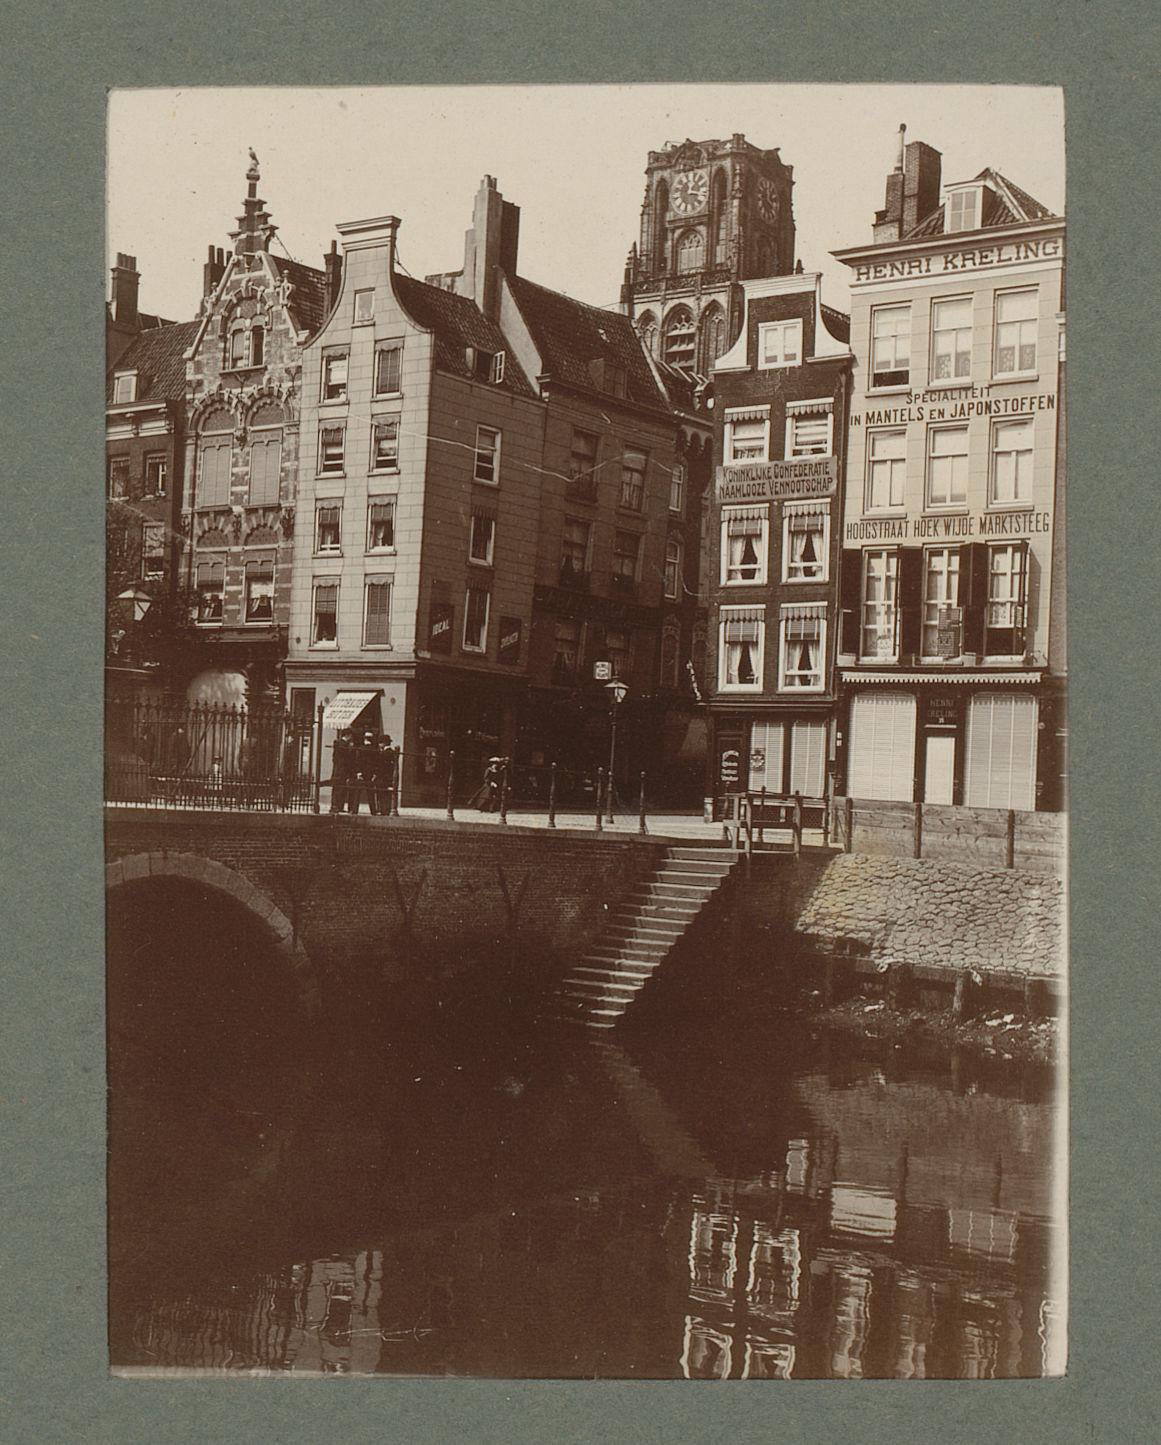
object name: album leaf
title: Gezicht op de Wijde Markt richting de Grote- of Sint-Laurenskerk te Rotterdam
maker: george hidderley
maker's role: fotograaf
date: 1900-1920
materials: photographic support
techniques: gelatin silver print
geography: rotterdam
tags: urban housing, canals, waters (in city), parts of church exterior and annexes: tower